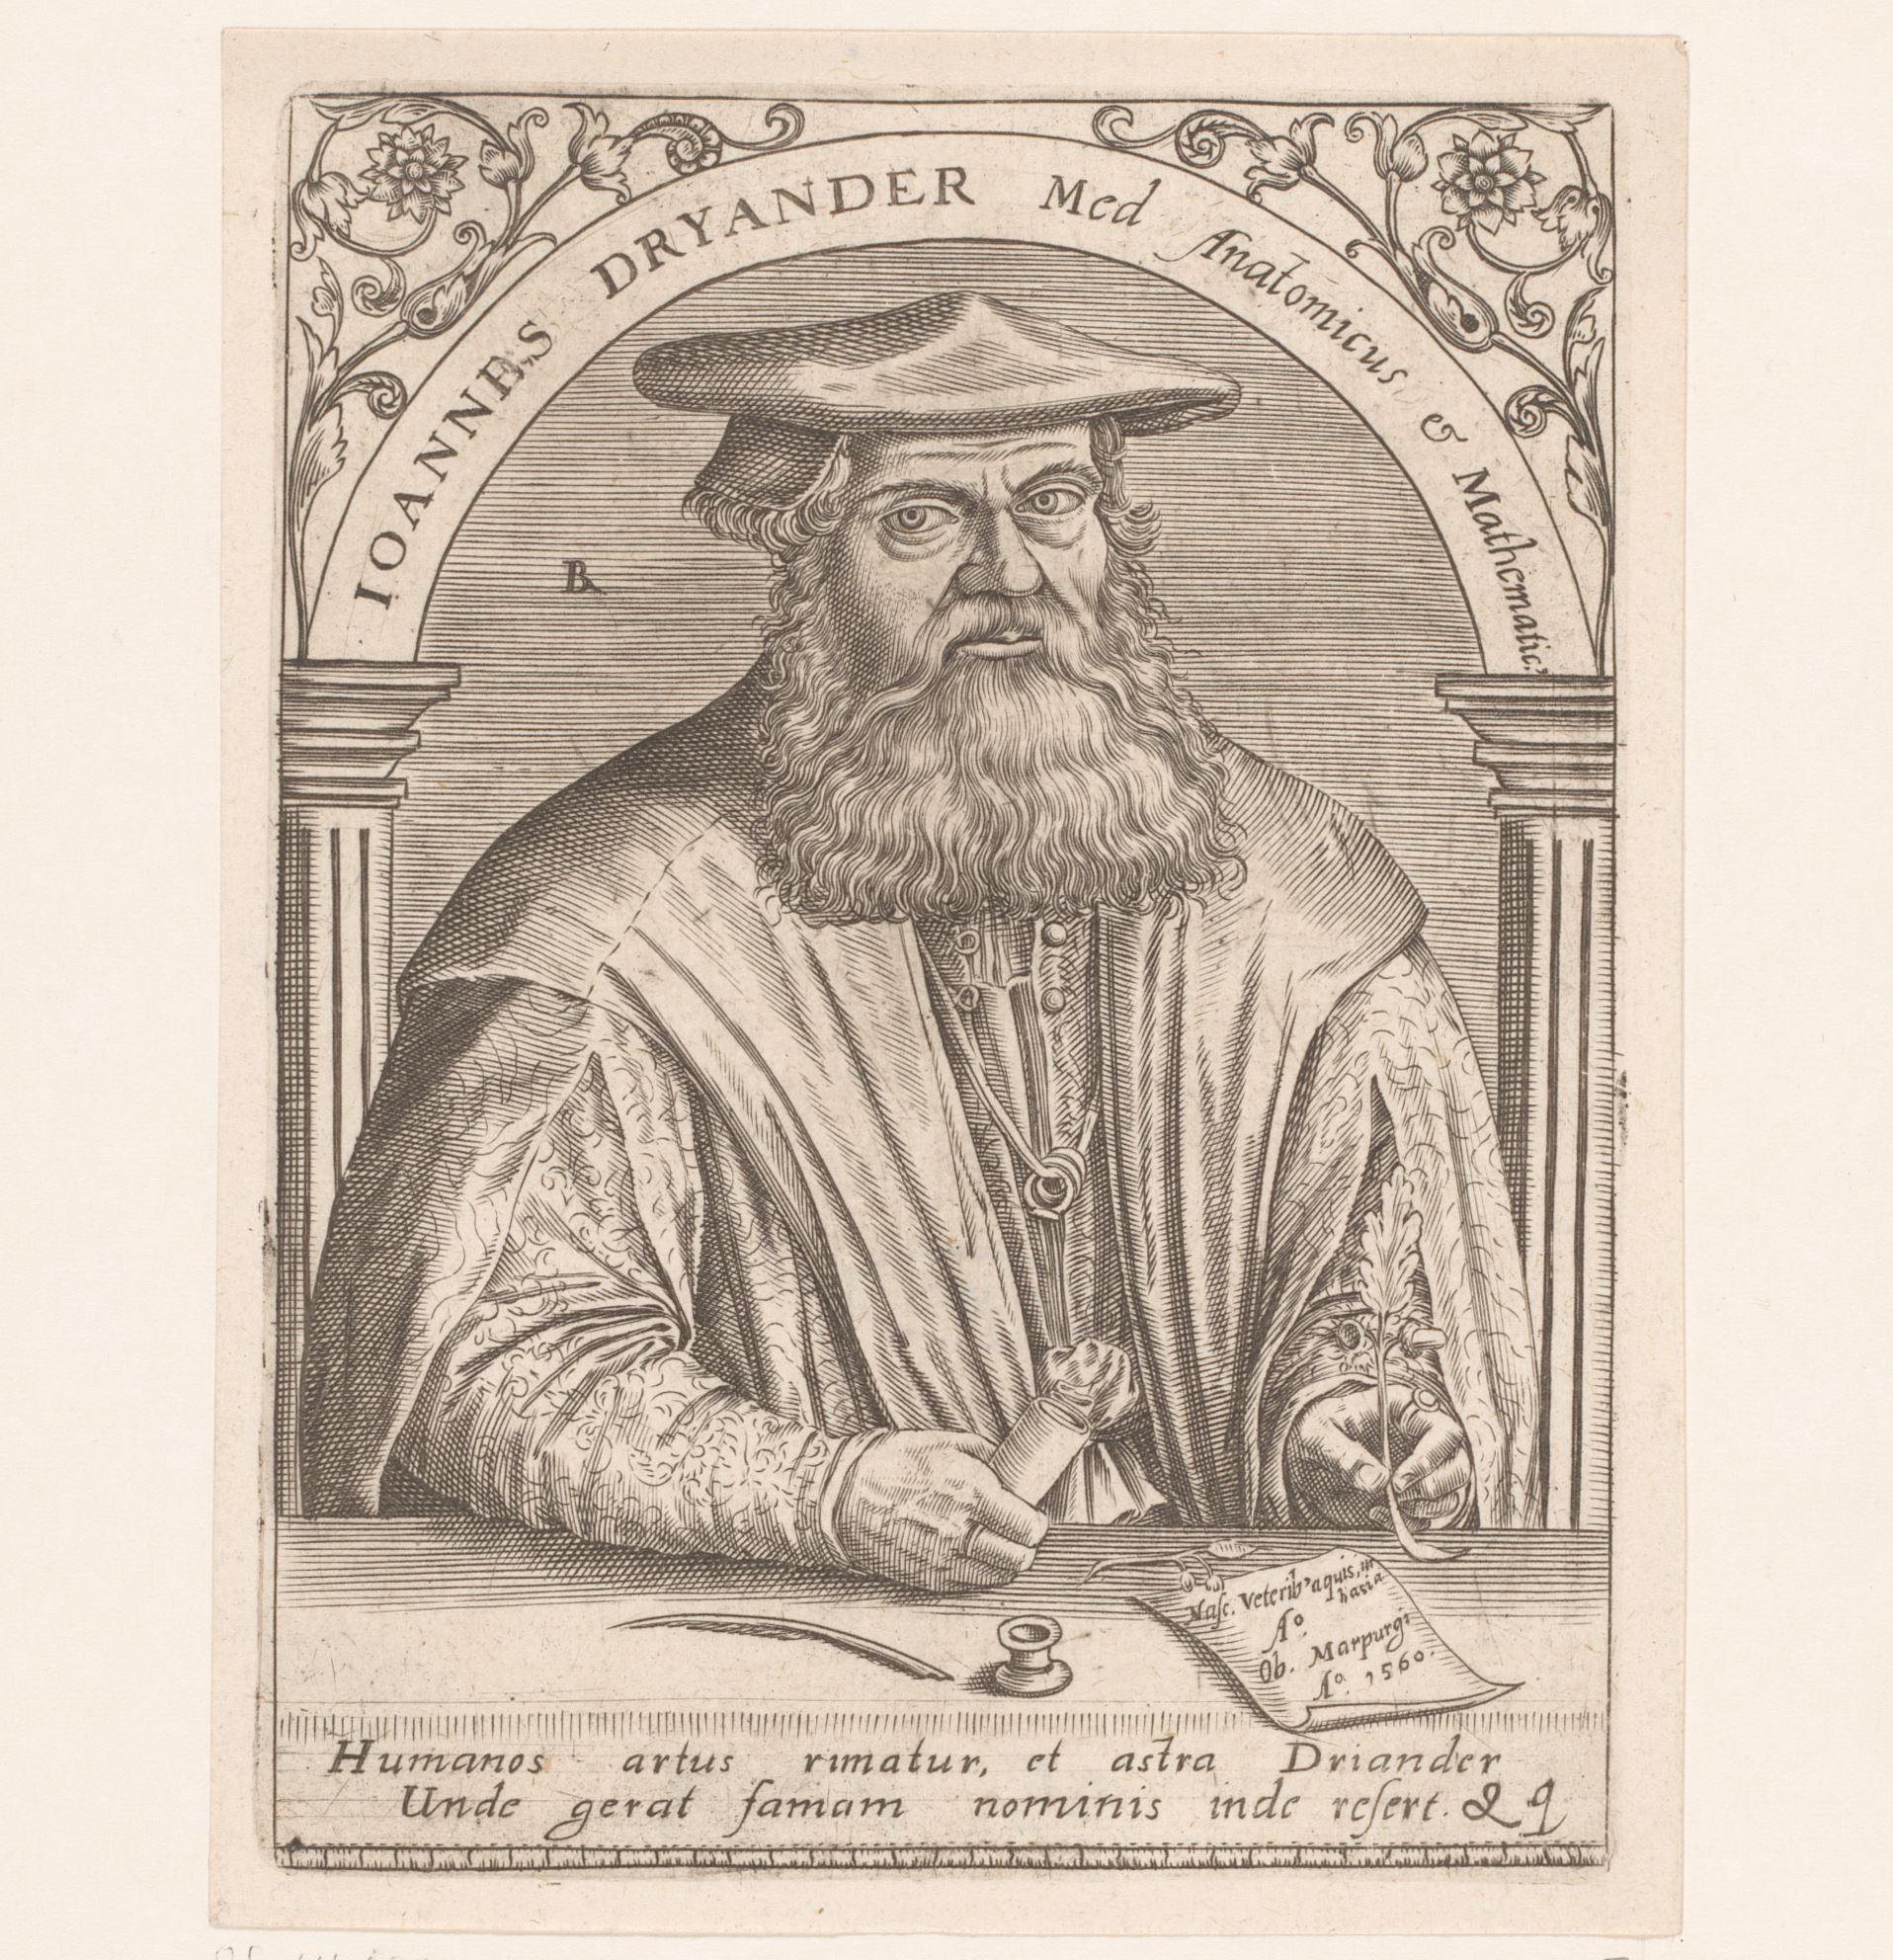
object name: print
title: Portret van Johann Dryander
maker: robert boissard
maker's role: print maker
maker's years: 1570-1611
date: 1597-1599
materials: paper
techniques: engraving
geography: france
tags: historical persons, trees: oak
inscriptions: collector's mark: Lugt 2228